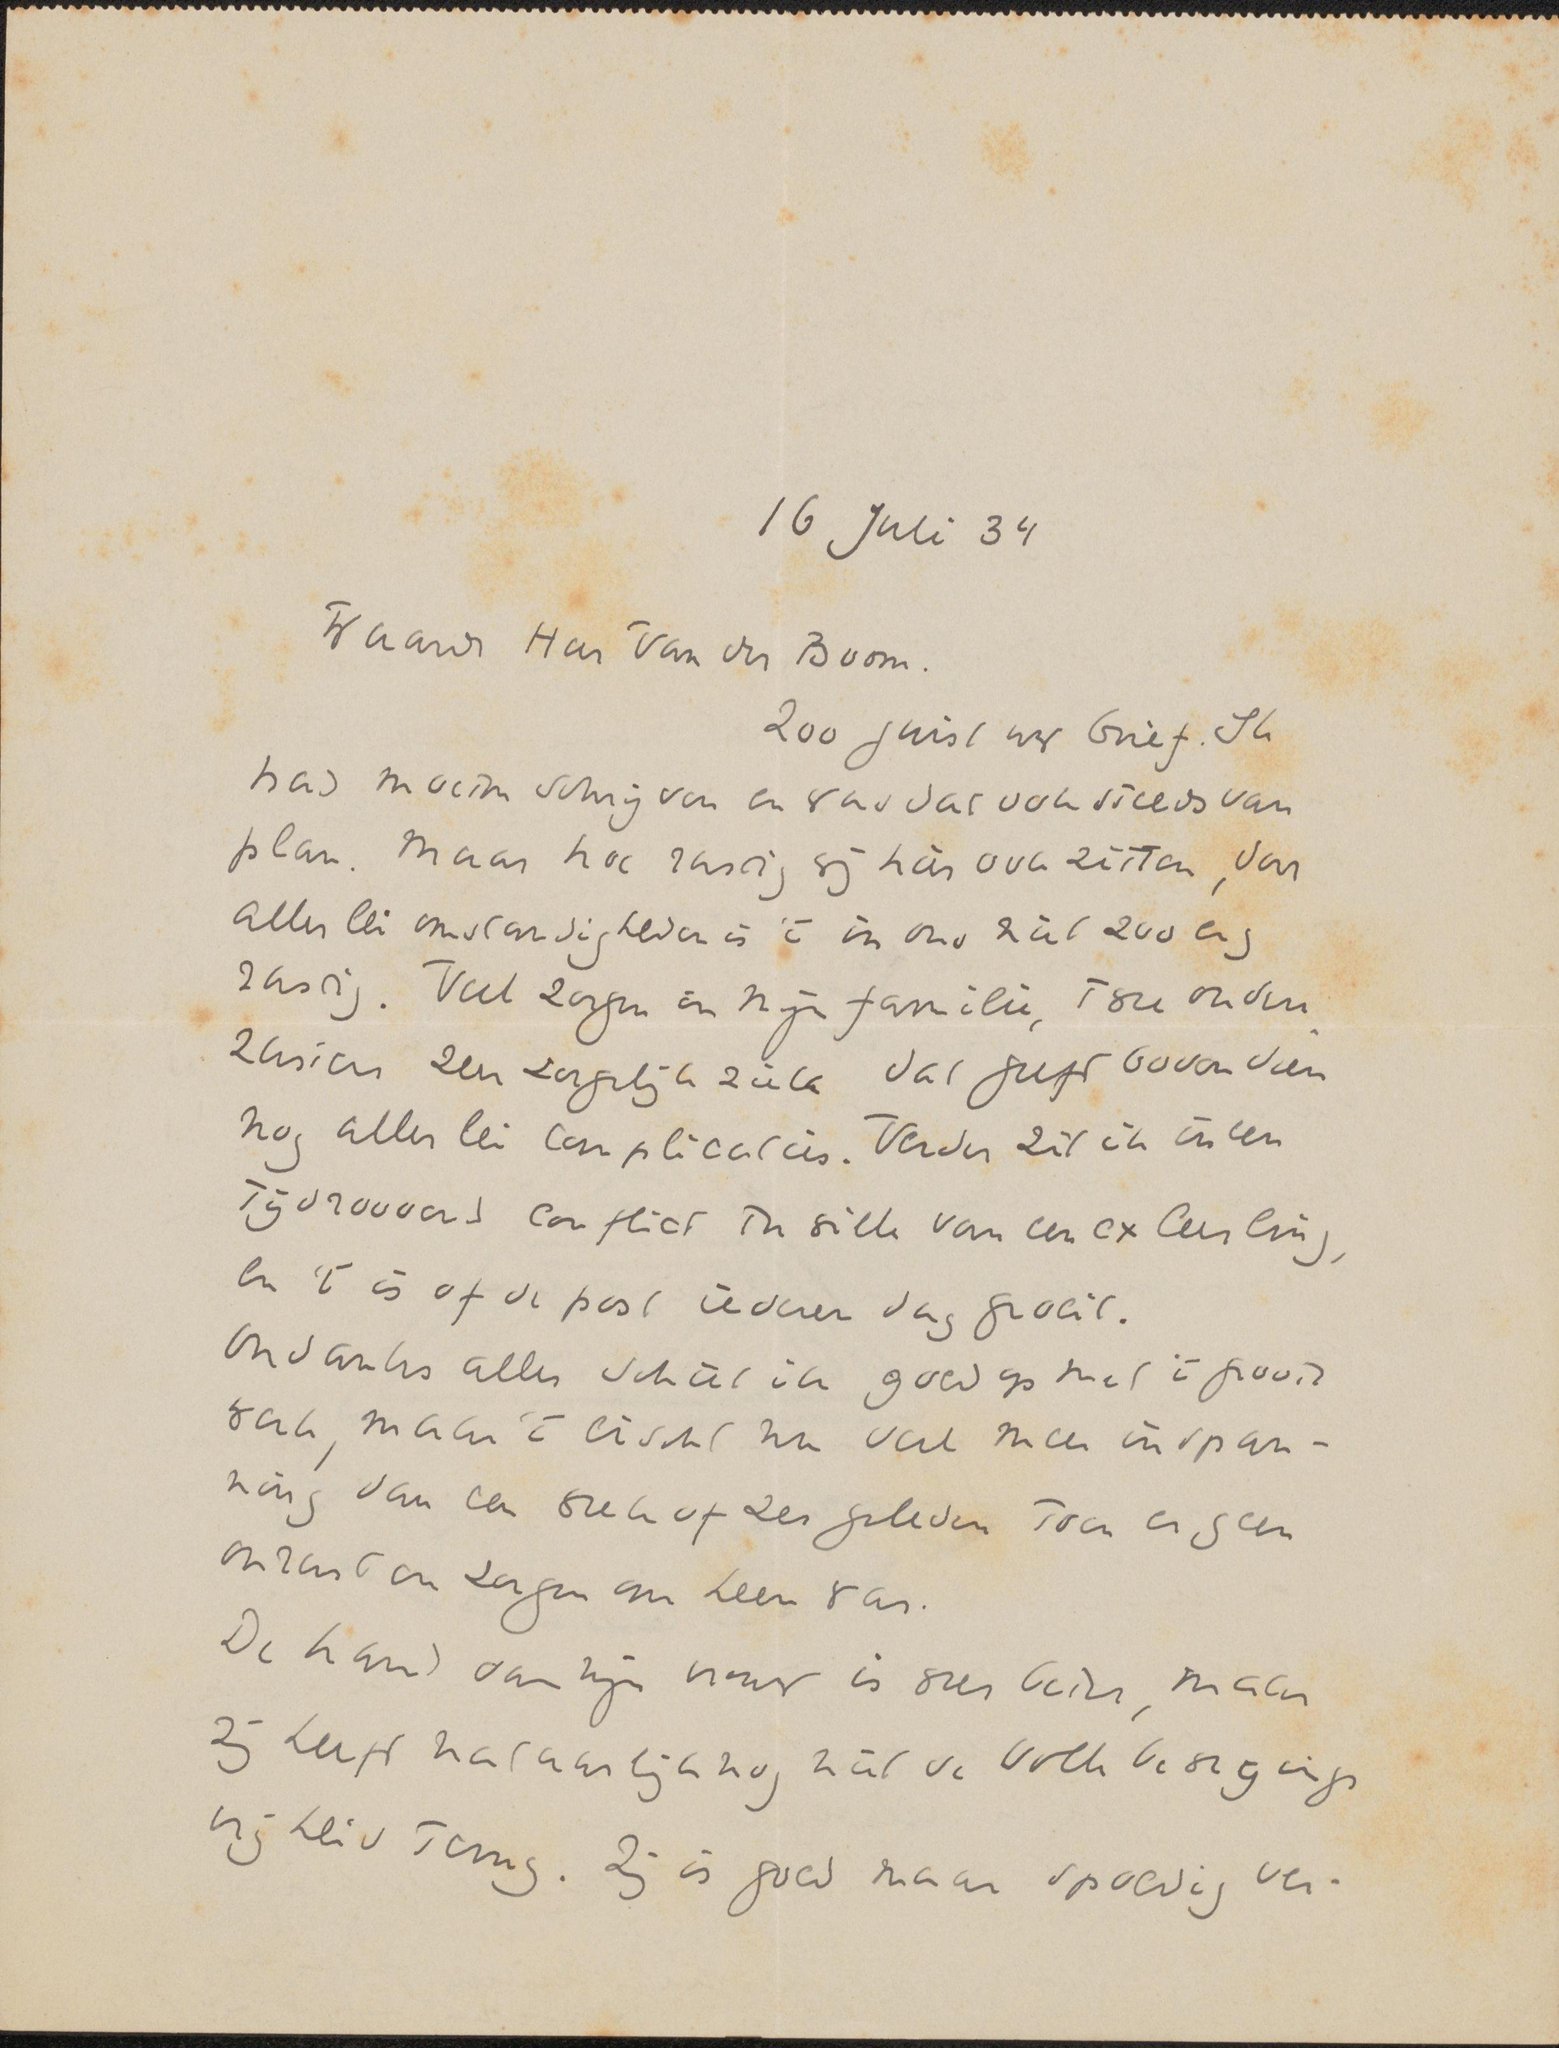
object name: letter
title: Brief aan A. van der Boom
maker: richard nicolaüs roland holst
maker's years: 1868-1938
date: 1934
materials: ink, paper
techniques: pen, writing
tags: a. van der boom, henriëtte roland holst-van der schalk, family life, diseases, belgium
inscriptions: watermark, collector's mark: Lugt L.2228a